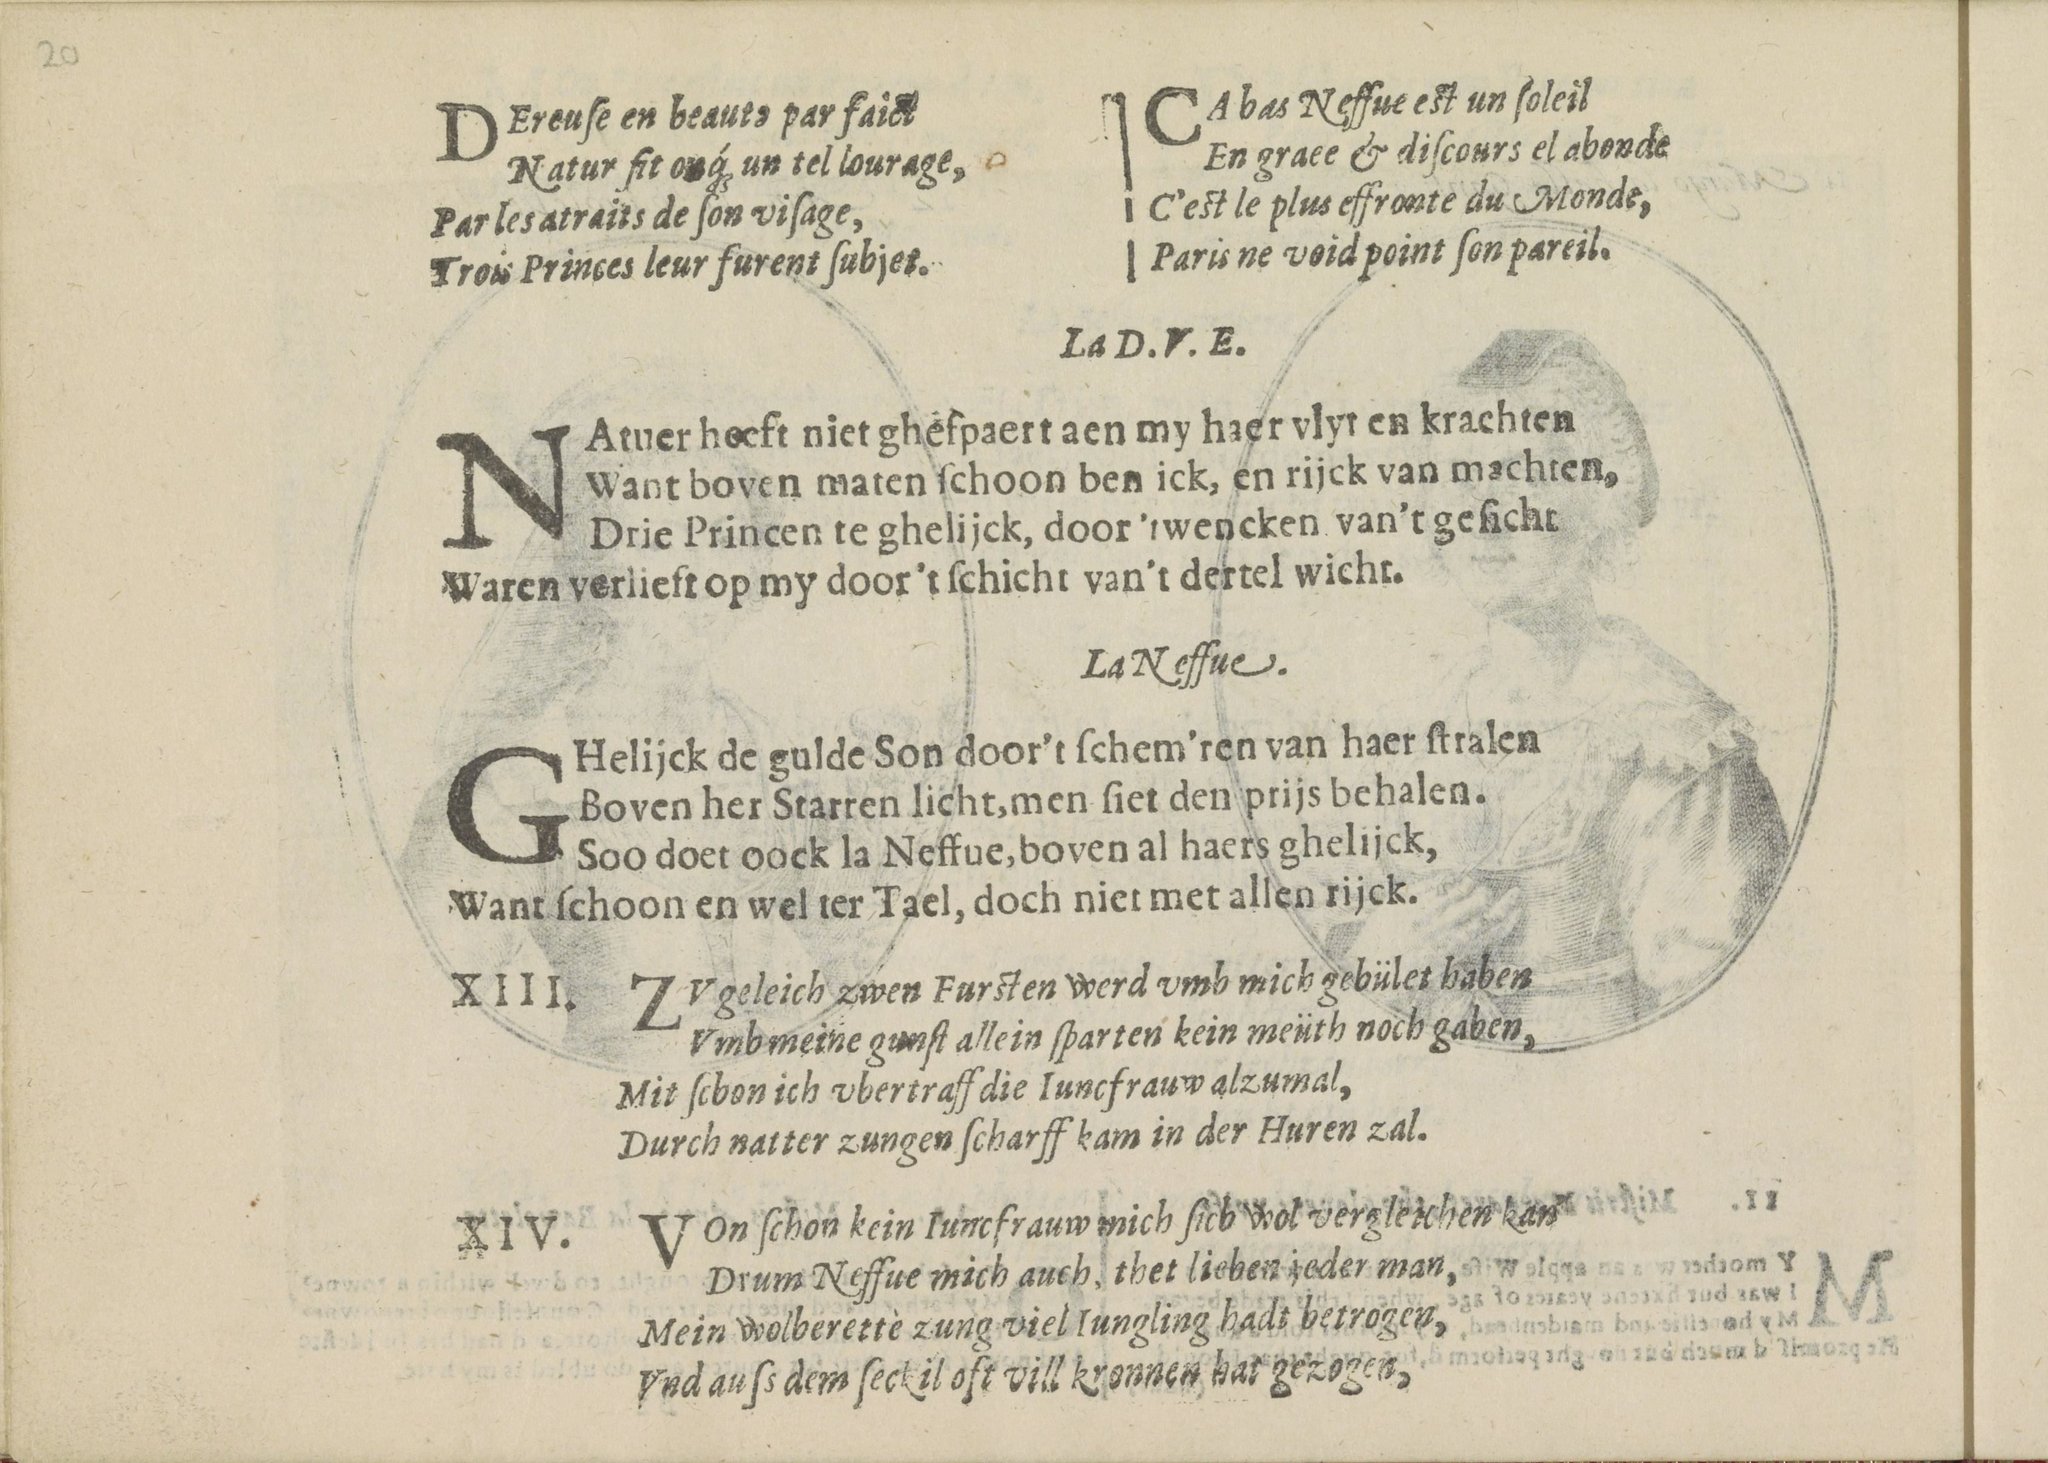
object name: text sheet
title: Kwatrijnen bij de portretten van de courtisanes genaamd Madame de D.V.E. en Madamoiselle La Neffue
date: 1635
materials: paper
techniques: letterpress printing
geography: utrecht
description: Drie keer twee kwatrijnen in het Frans, Nederlands en Duits bij de portretten van de courtisanes genaamd Madame de D.V.E. en Madamoiselle La Neffue. Het blad maakt deel uit van een album.